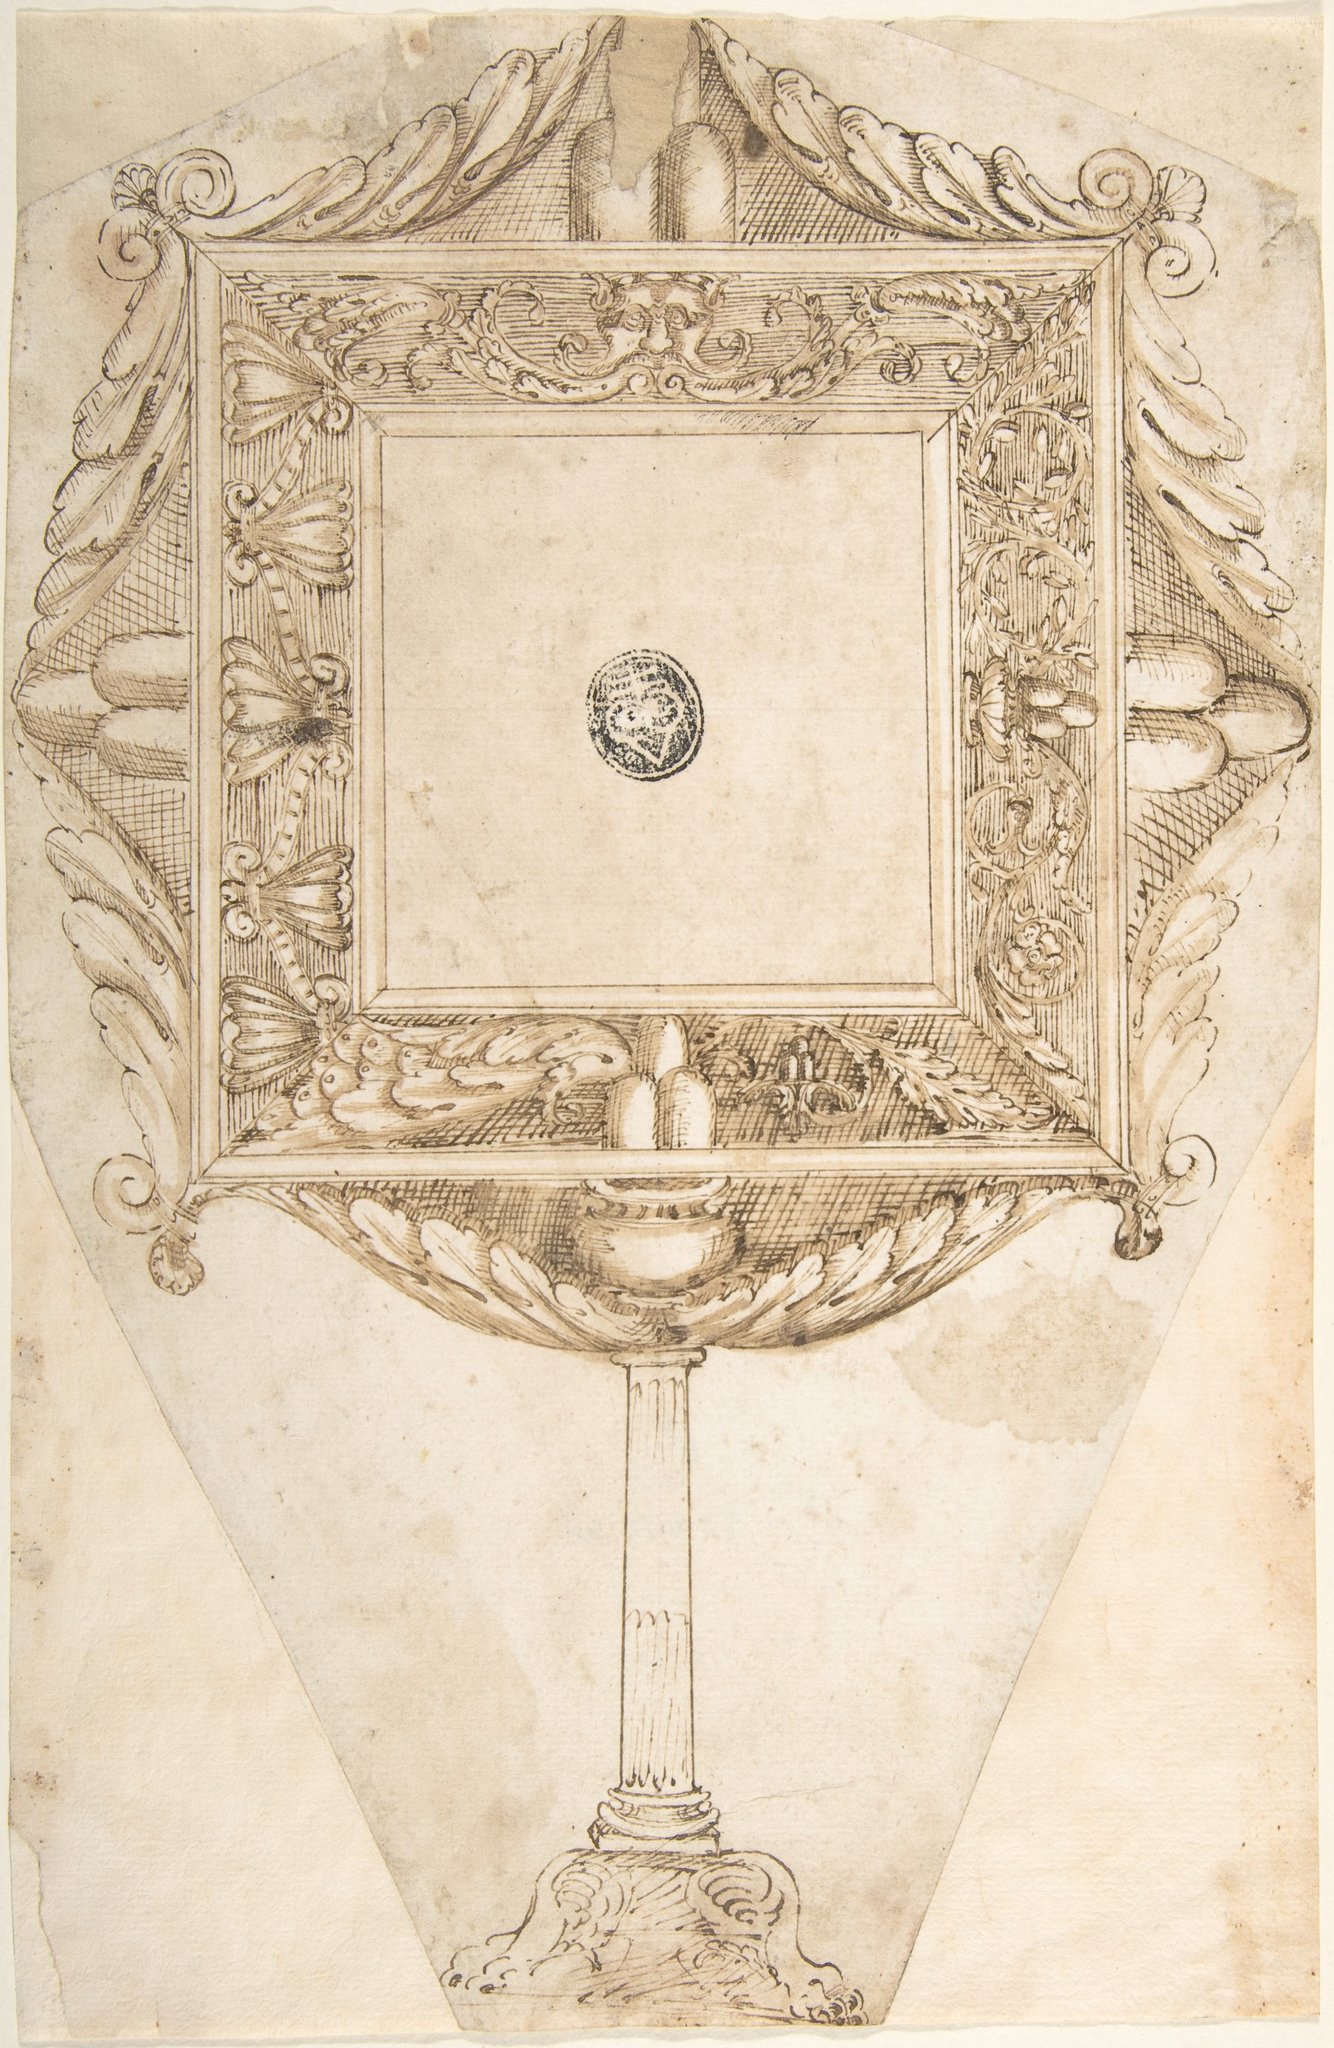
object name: drawing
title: Design for a Mirror with the Sigil of Three Mountains (Family Crest of the Monti?)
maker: anonymous, italian, 16th century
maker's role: artist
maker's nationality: italian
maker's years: 1550-1600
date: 1501-1600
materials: ink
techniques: brush, pen, wash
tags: faces,mountains,mirrors